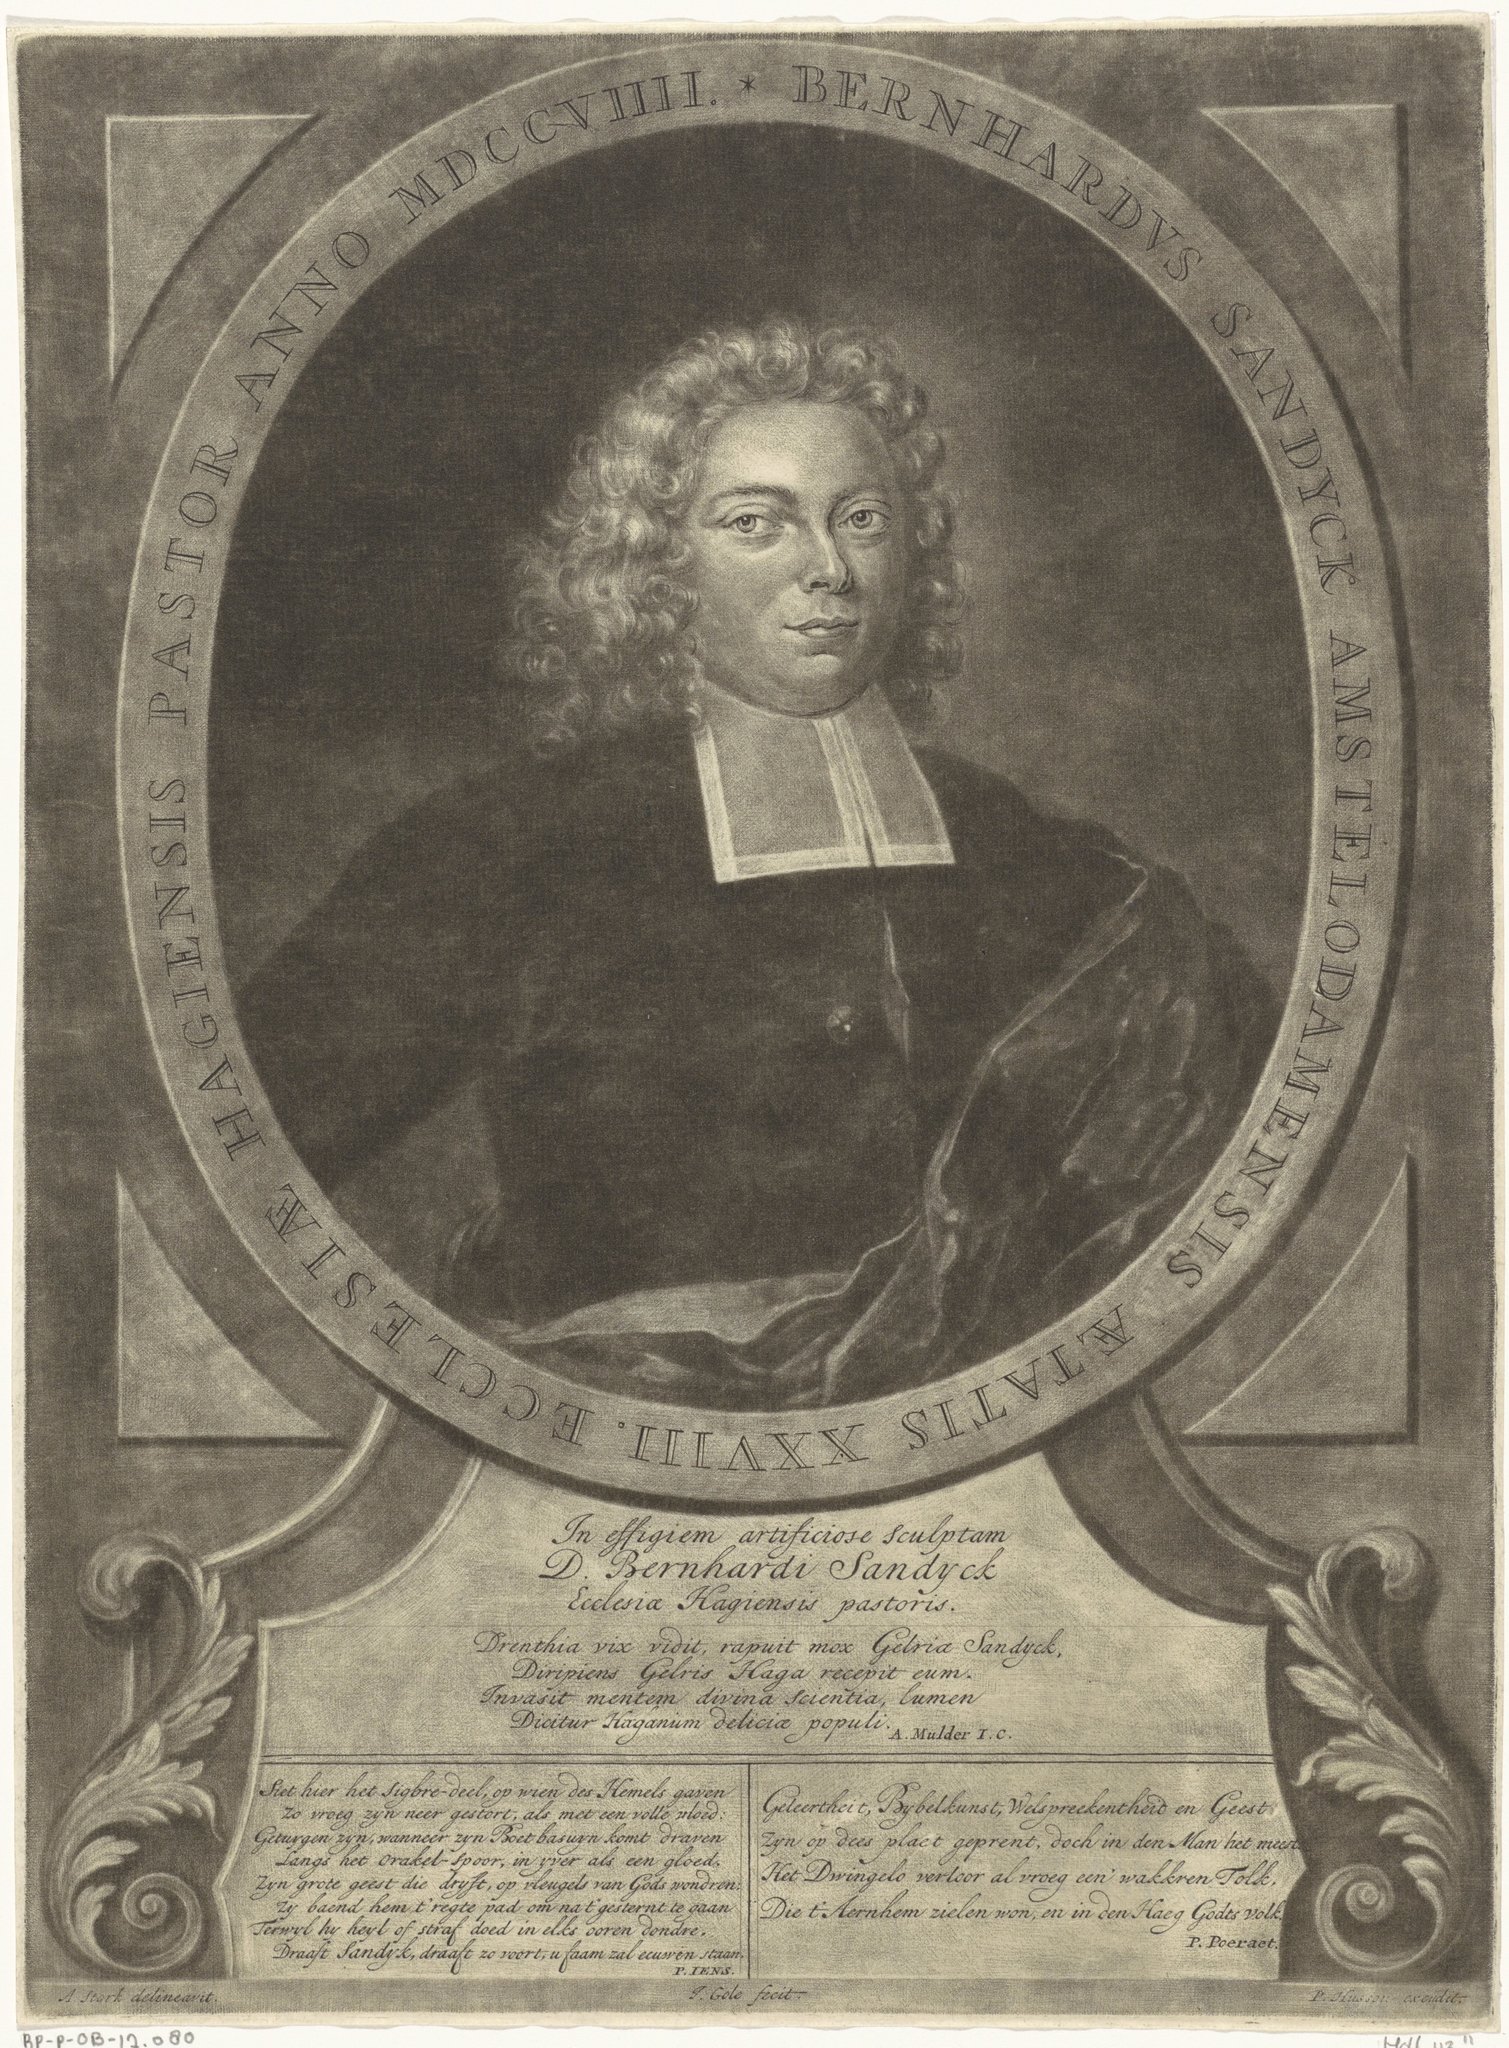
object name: print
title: Portret van Bernardus Sandijk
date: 1709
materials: paper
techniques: engraving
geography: the hague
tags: theologian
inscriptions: collector's mark: Lugt 2228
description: De predikant Bernardus Sandijk op 28-jarige leeftijd.